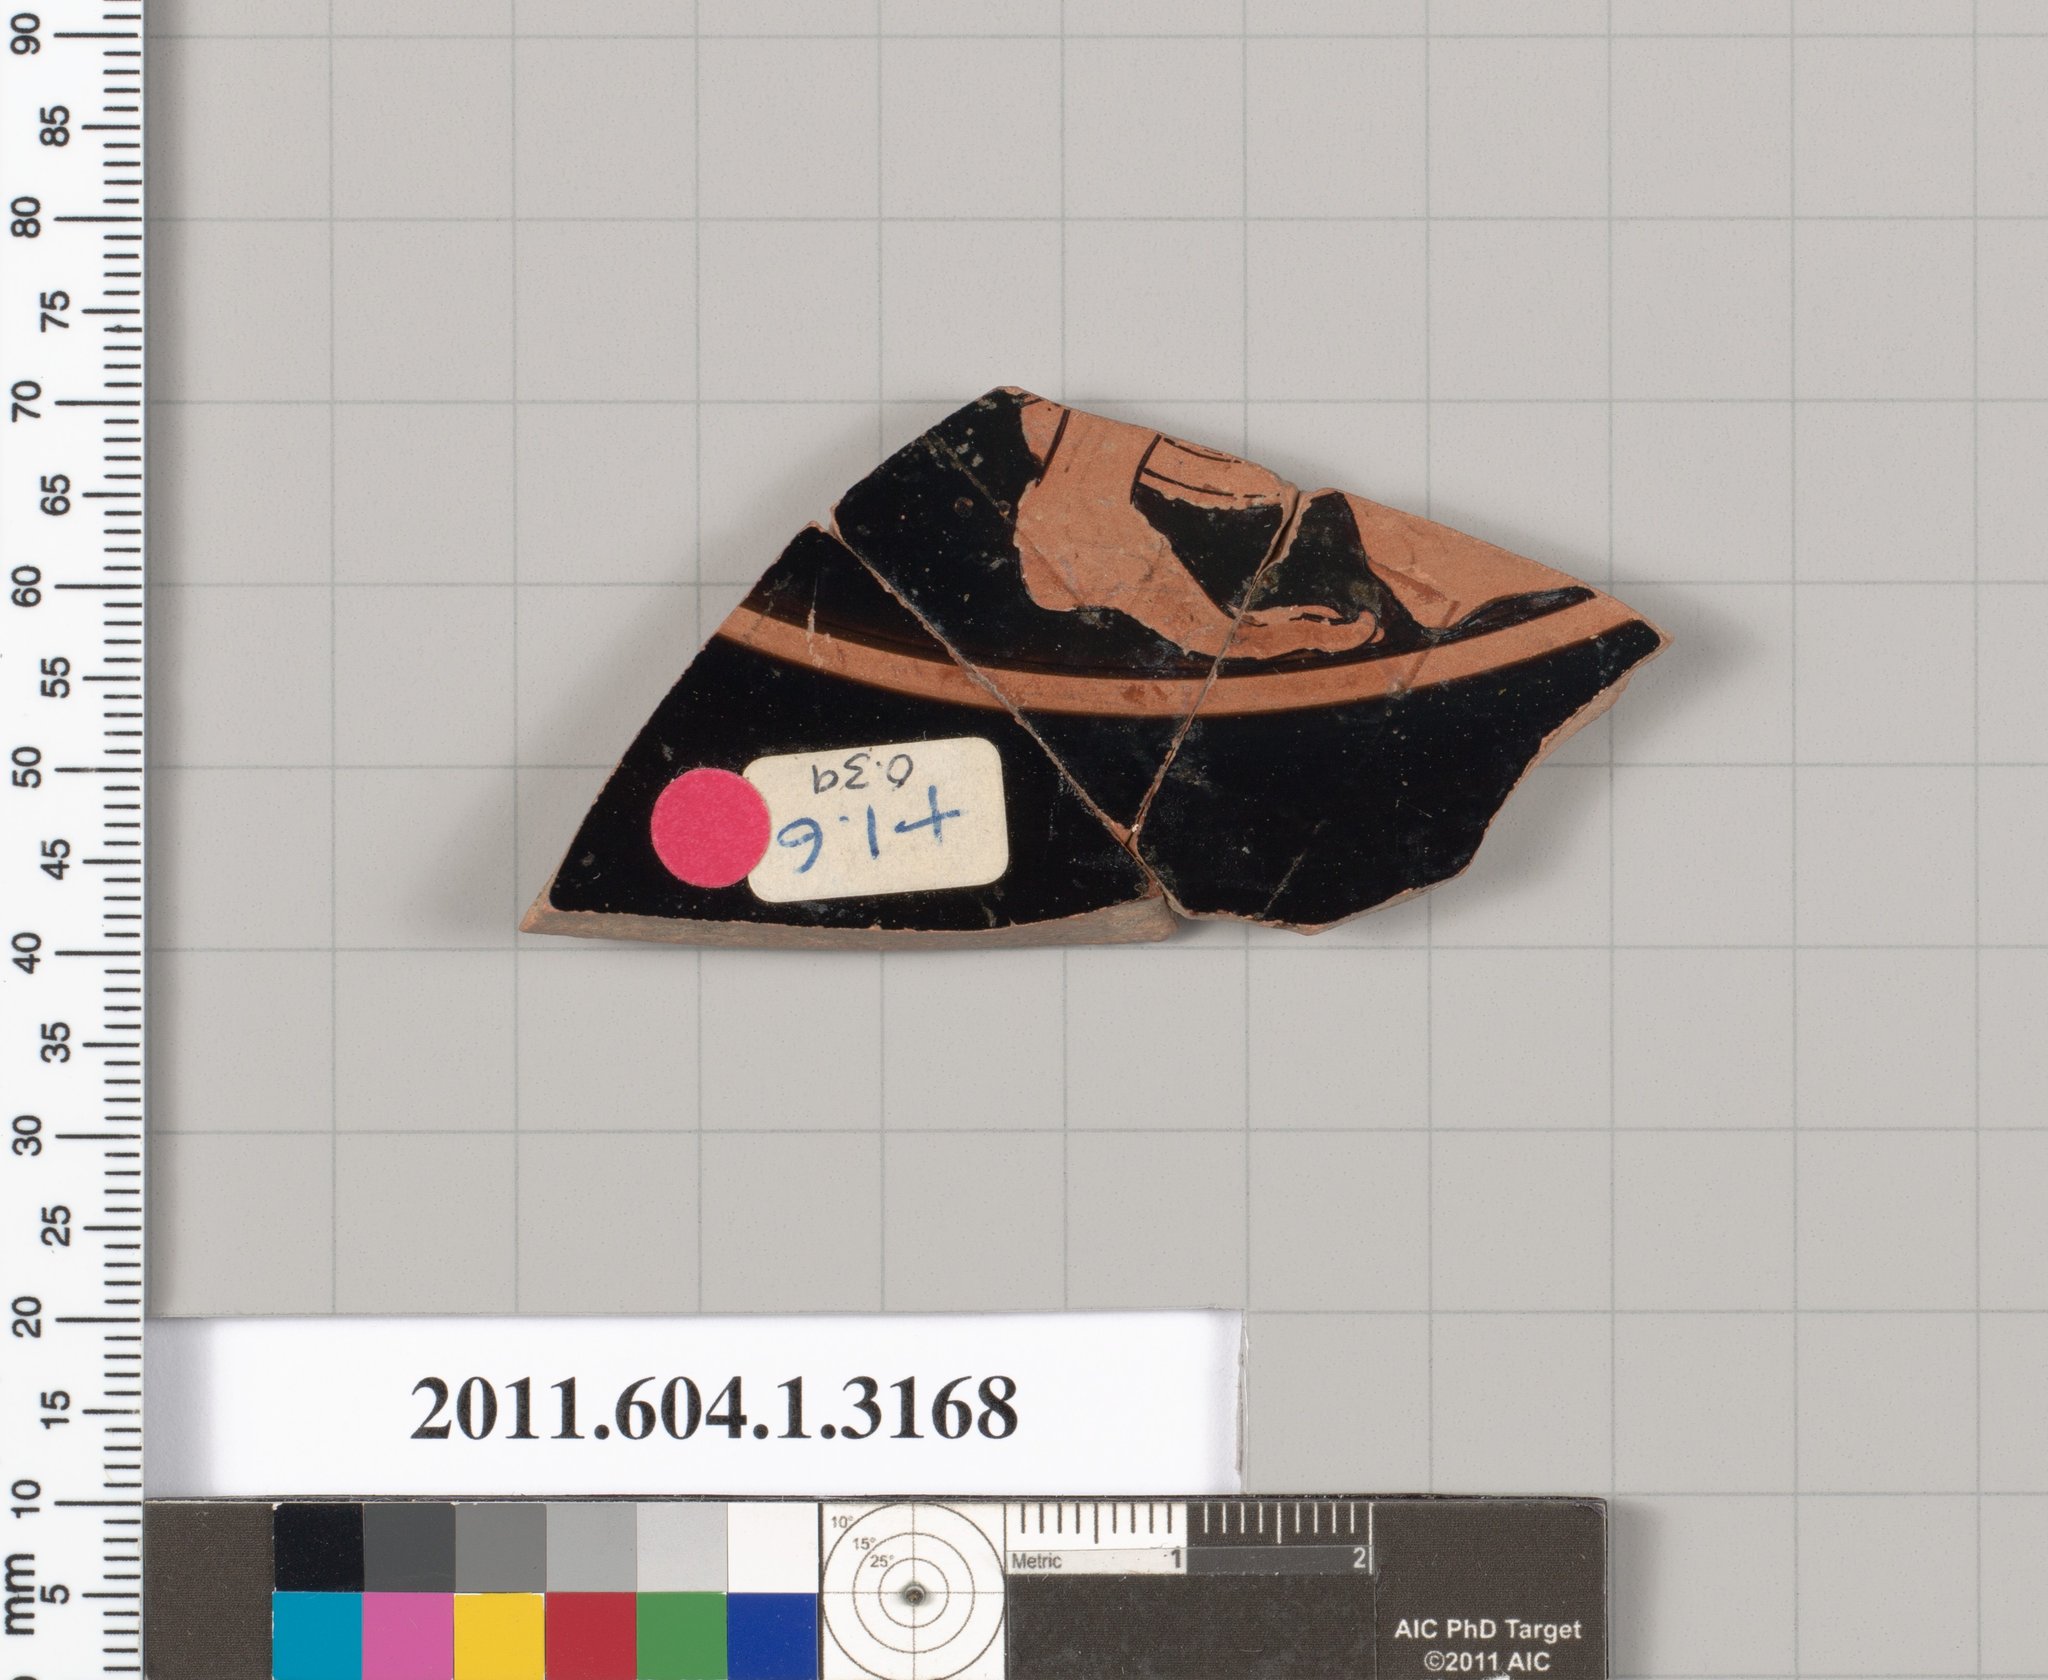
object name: kylix fragment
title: Terracotta fragment of a kylix (drinking cup)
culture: greek, attic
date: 510-490 BCE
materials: terracotta